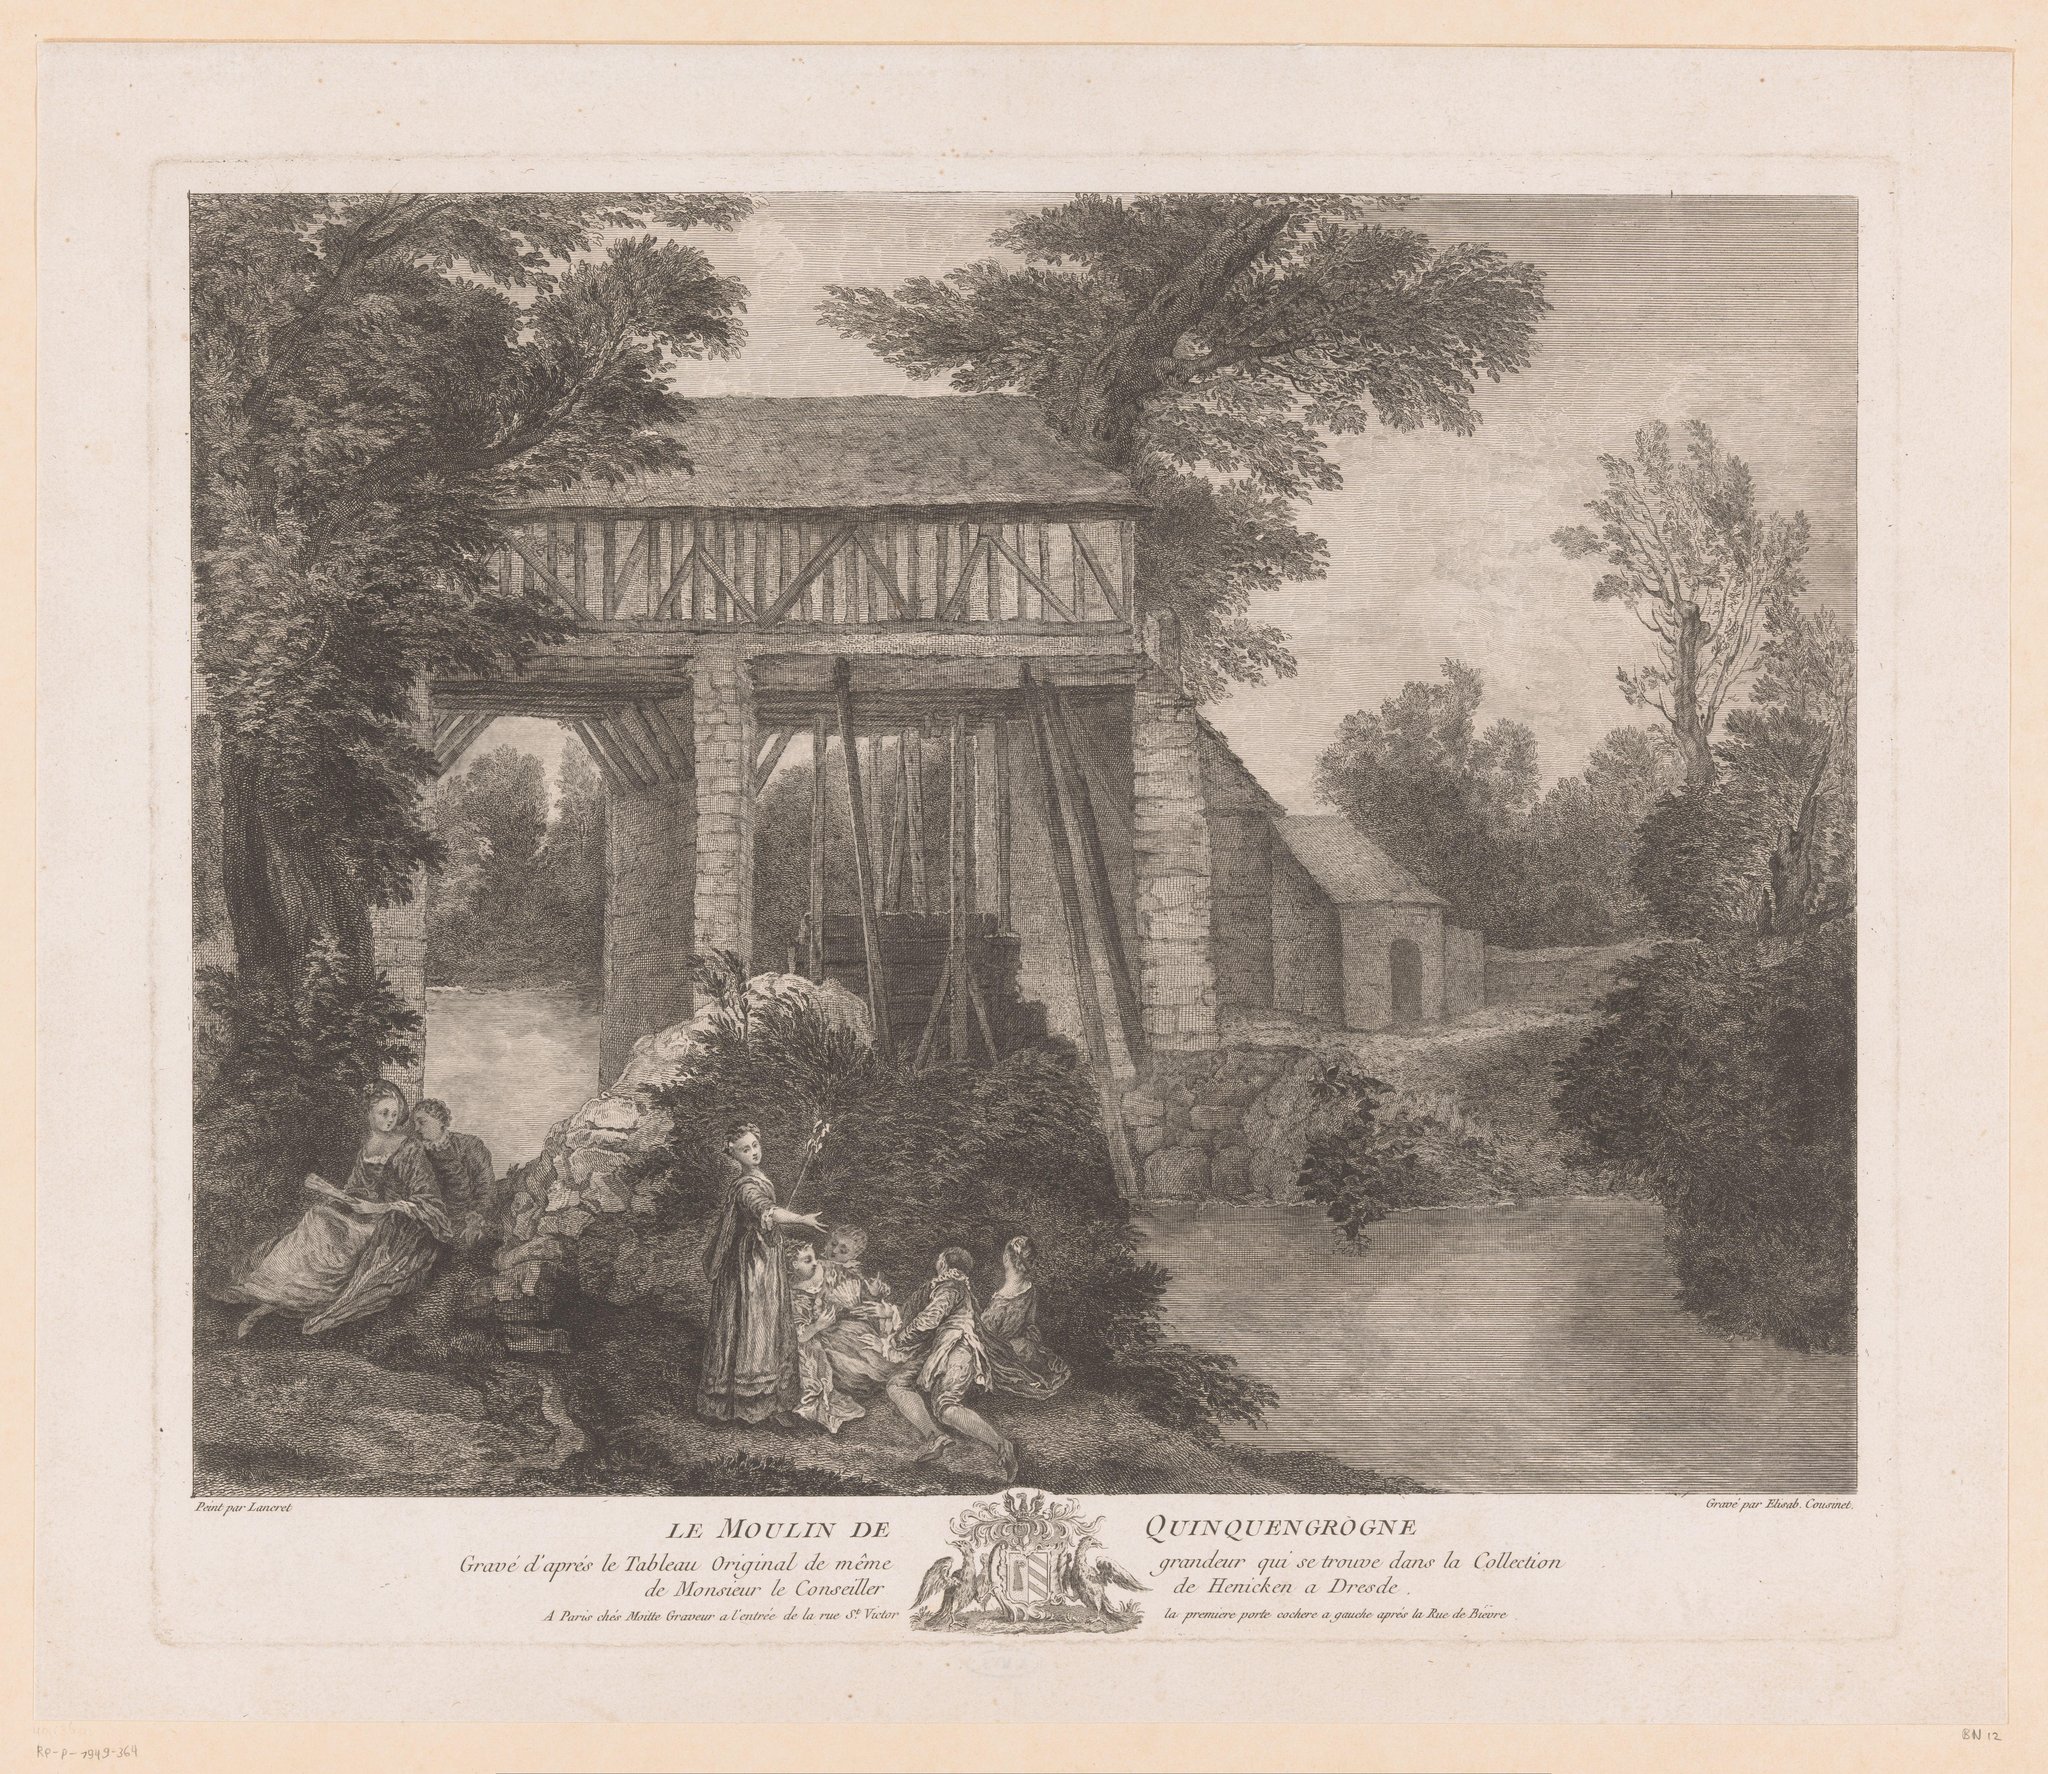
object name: print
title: Vier vrouwen en drie mannen bij een watermolen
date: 1762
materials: paper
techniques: engraving, etching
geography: paris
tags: watermill, resting - bb - out of doors, armorial bearing, heraldry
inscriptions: collector's mark: Lugt 2228